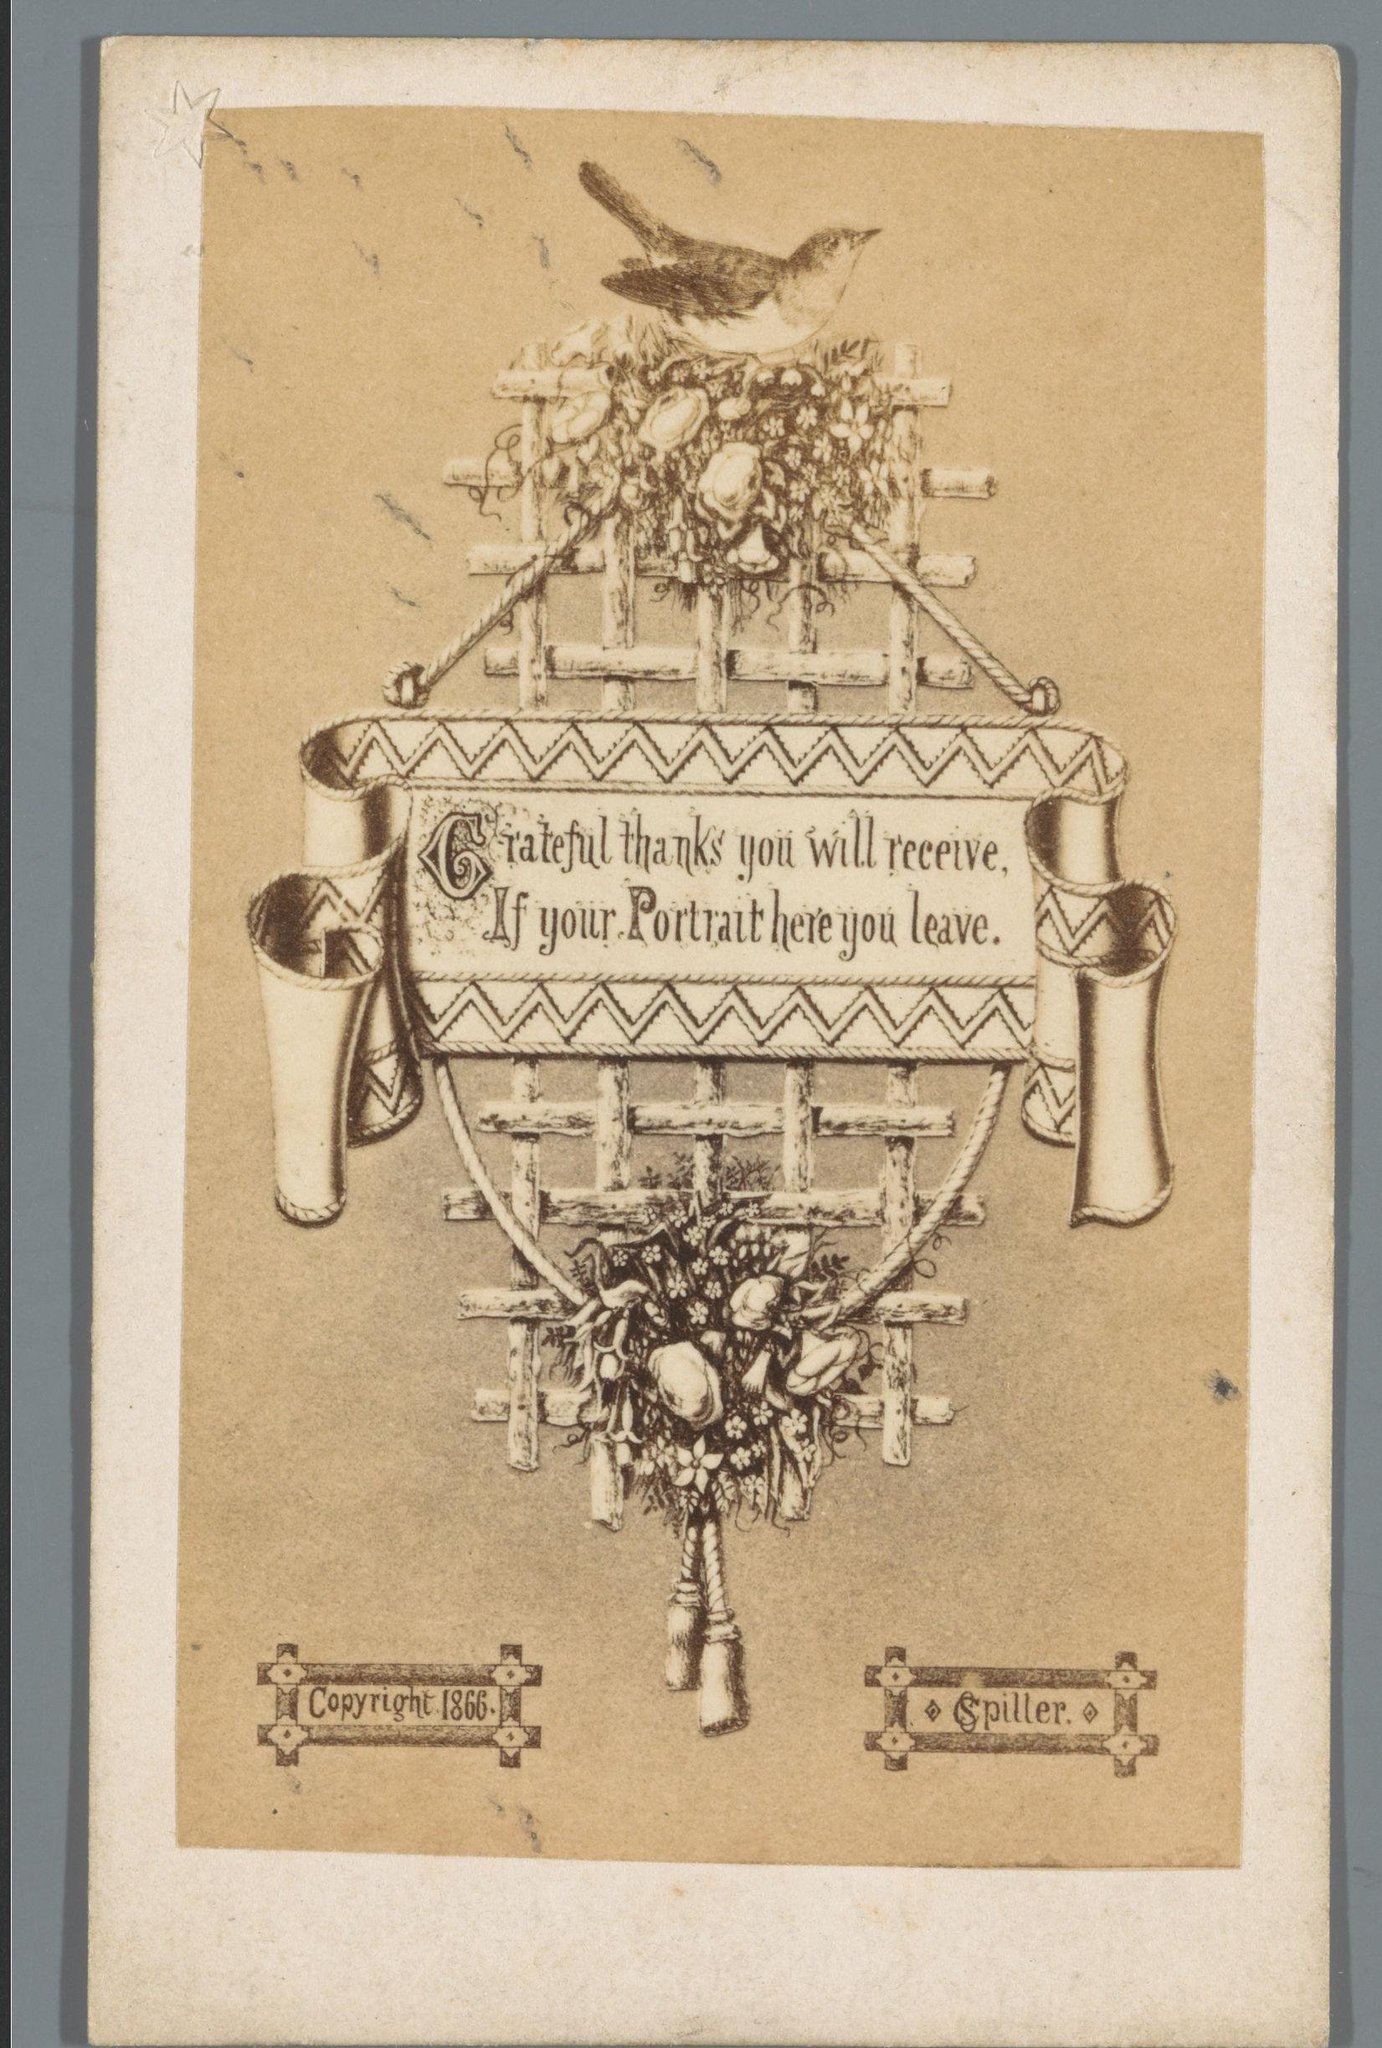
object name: carte de visite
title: Fotoreproductie van een prent met de spreuk Grateful thanks you will receive, if your Portrait here you leave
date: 1866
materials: cardboard, paper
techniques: albumen print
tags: ornament derived from animal forms, flowers ~ ornament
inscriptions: inscription: ‘10’, copyright notice: ‘Copyright 1866 C. Spiller’